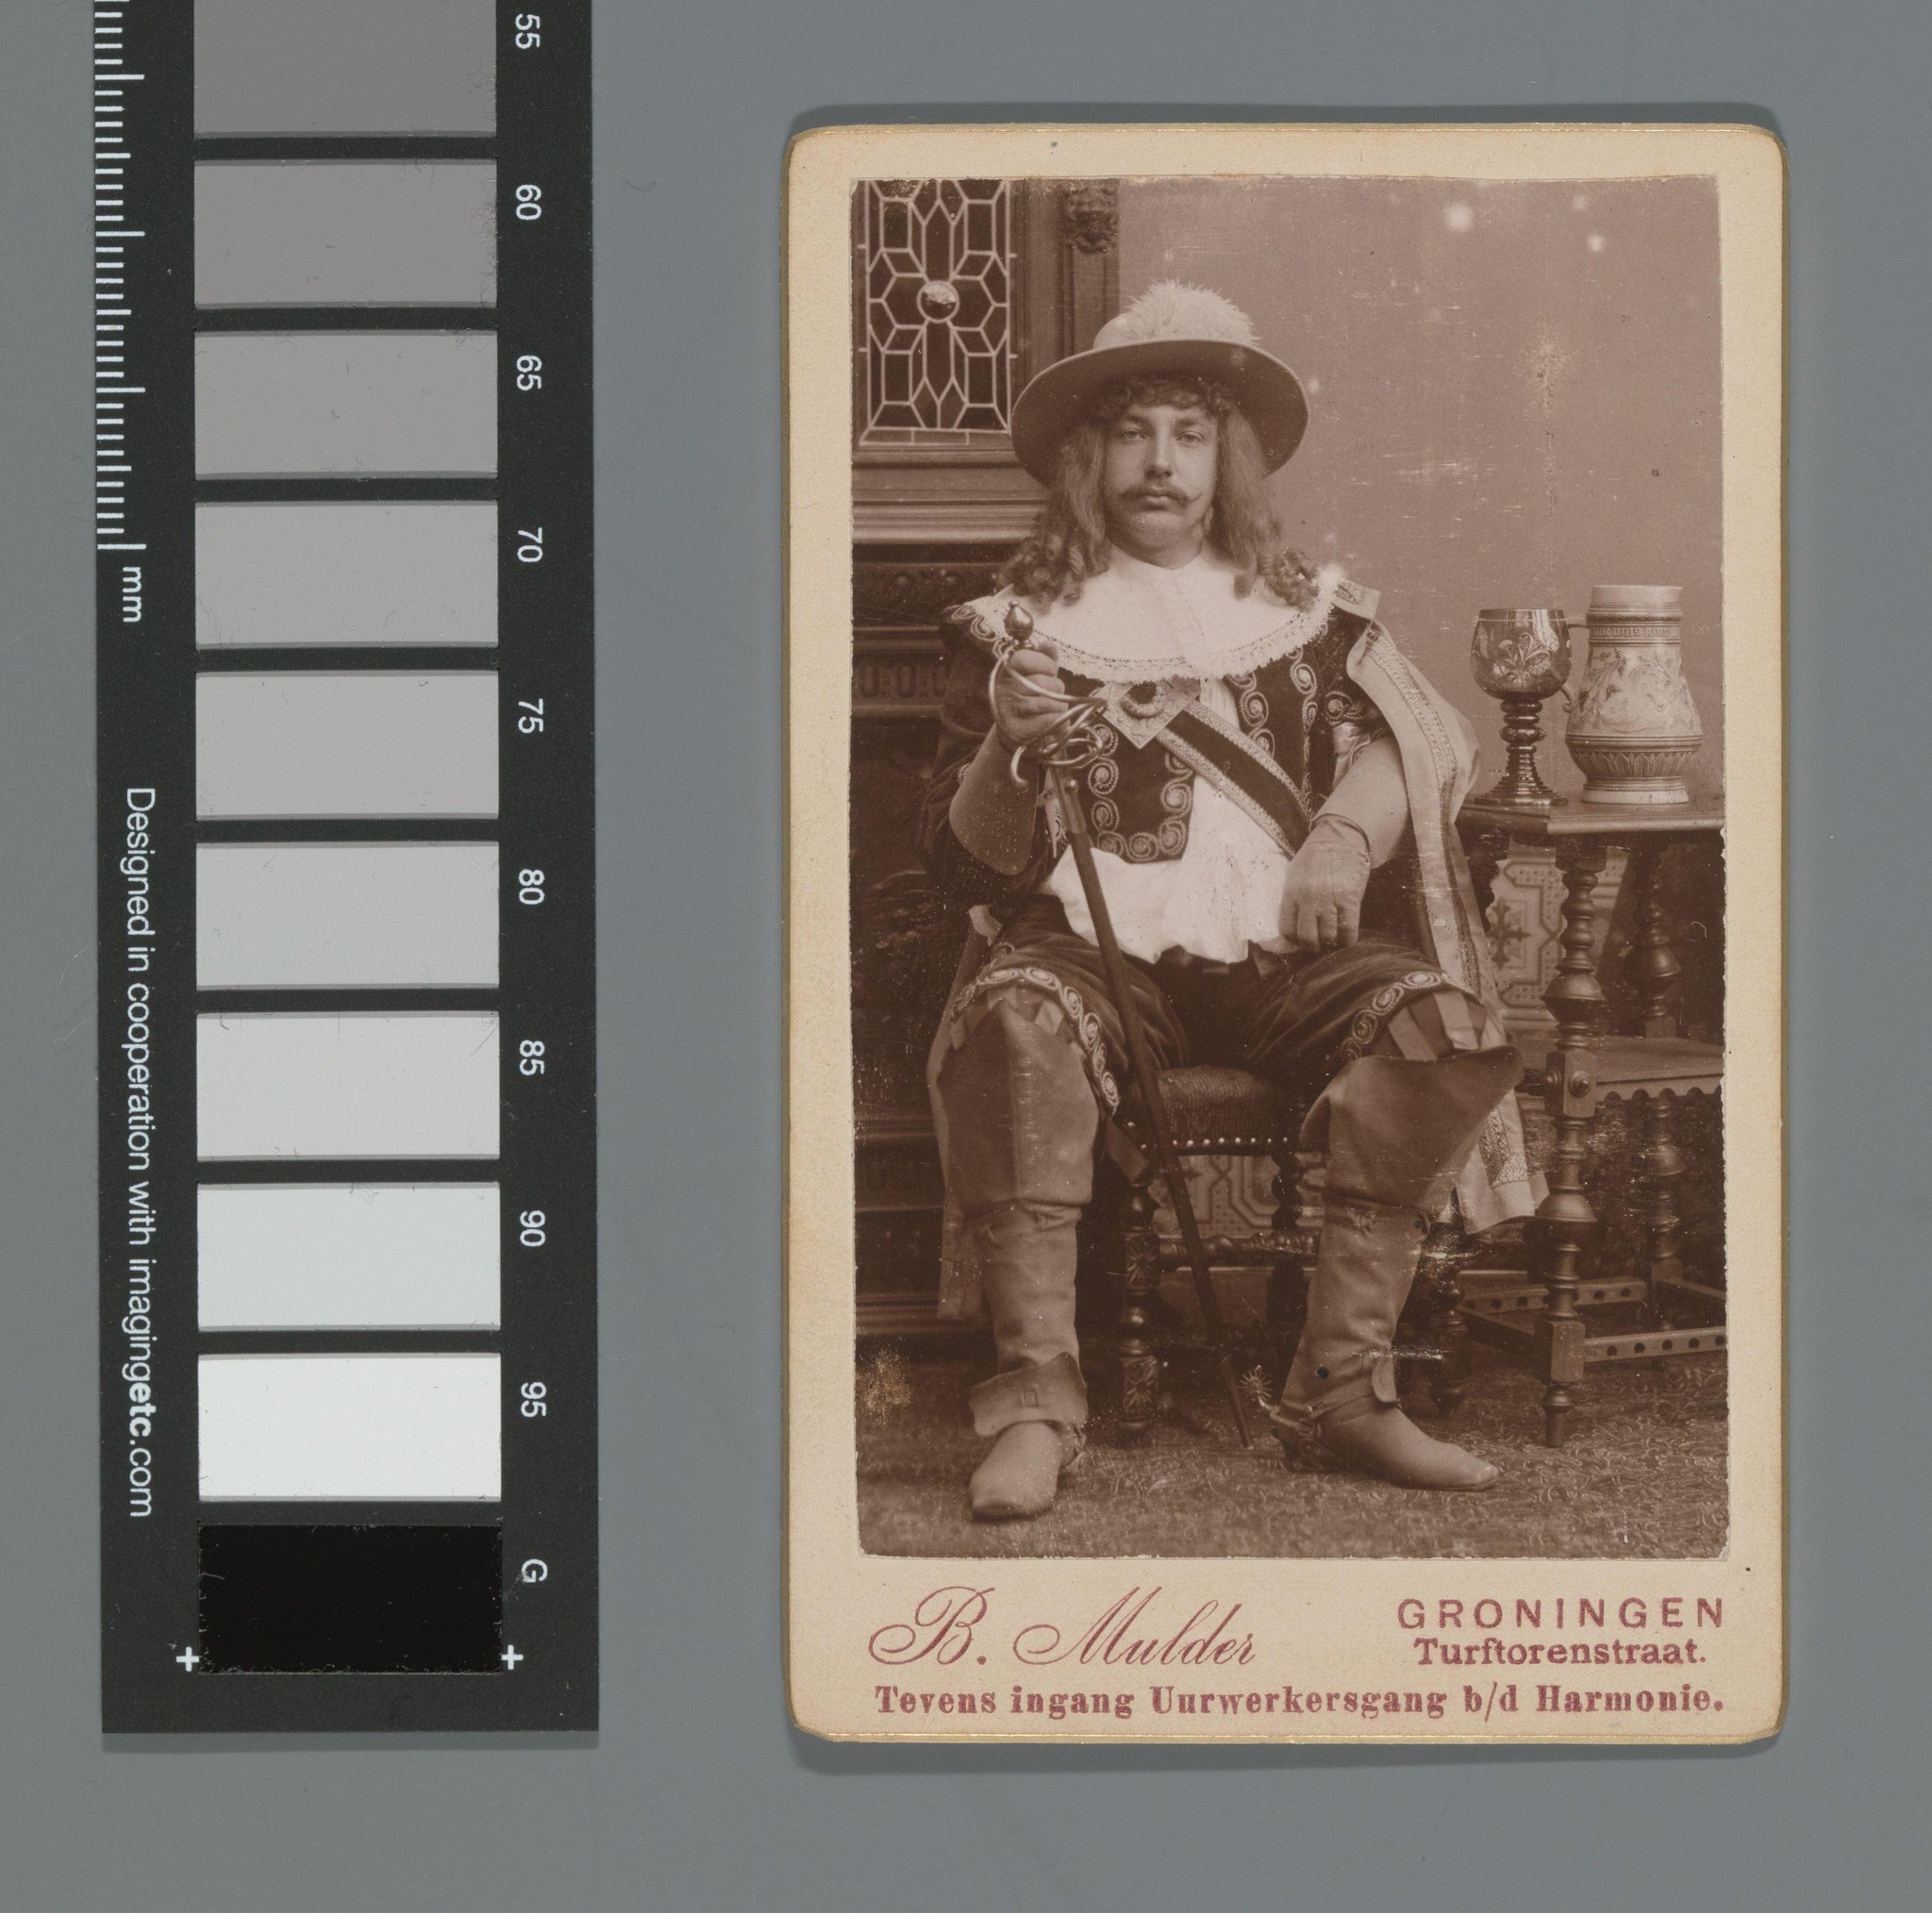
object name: photograph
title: Portret van een onbekende Groningse student in maskeradekostuum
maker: berend mulder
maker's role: fotograaf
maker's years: 1854-1926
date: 1886-1897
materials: paper, cardboard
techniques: collodion silver print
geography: groningen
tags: students' pageant, costumes used in pageants, anonymous historical person portrayed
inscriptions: inscription: ‘B. Mulder/ Groningen/ Turftorenstraat./ Tevens ingang Uurwerksgang b/d Harmonie’